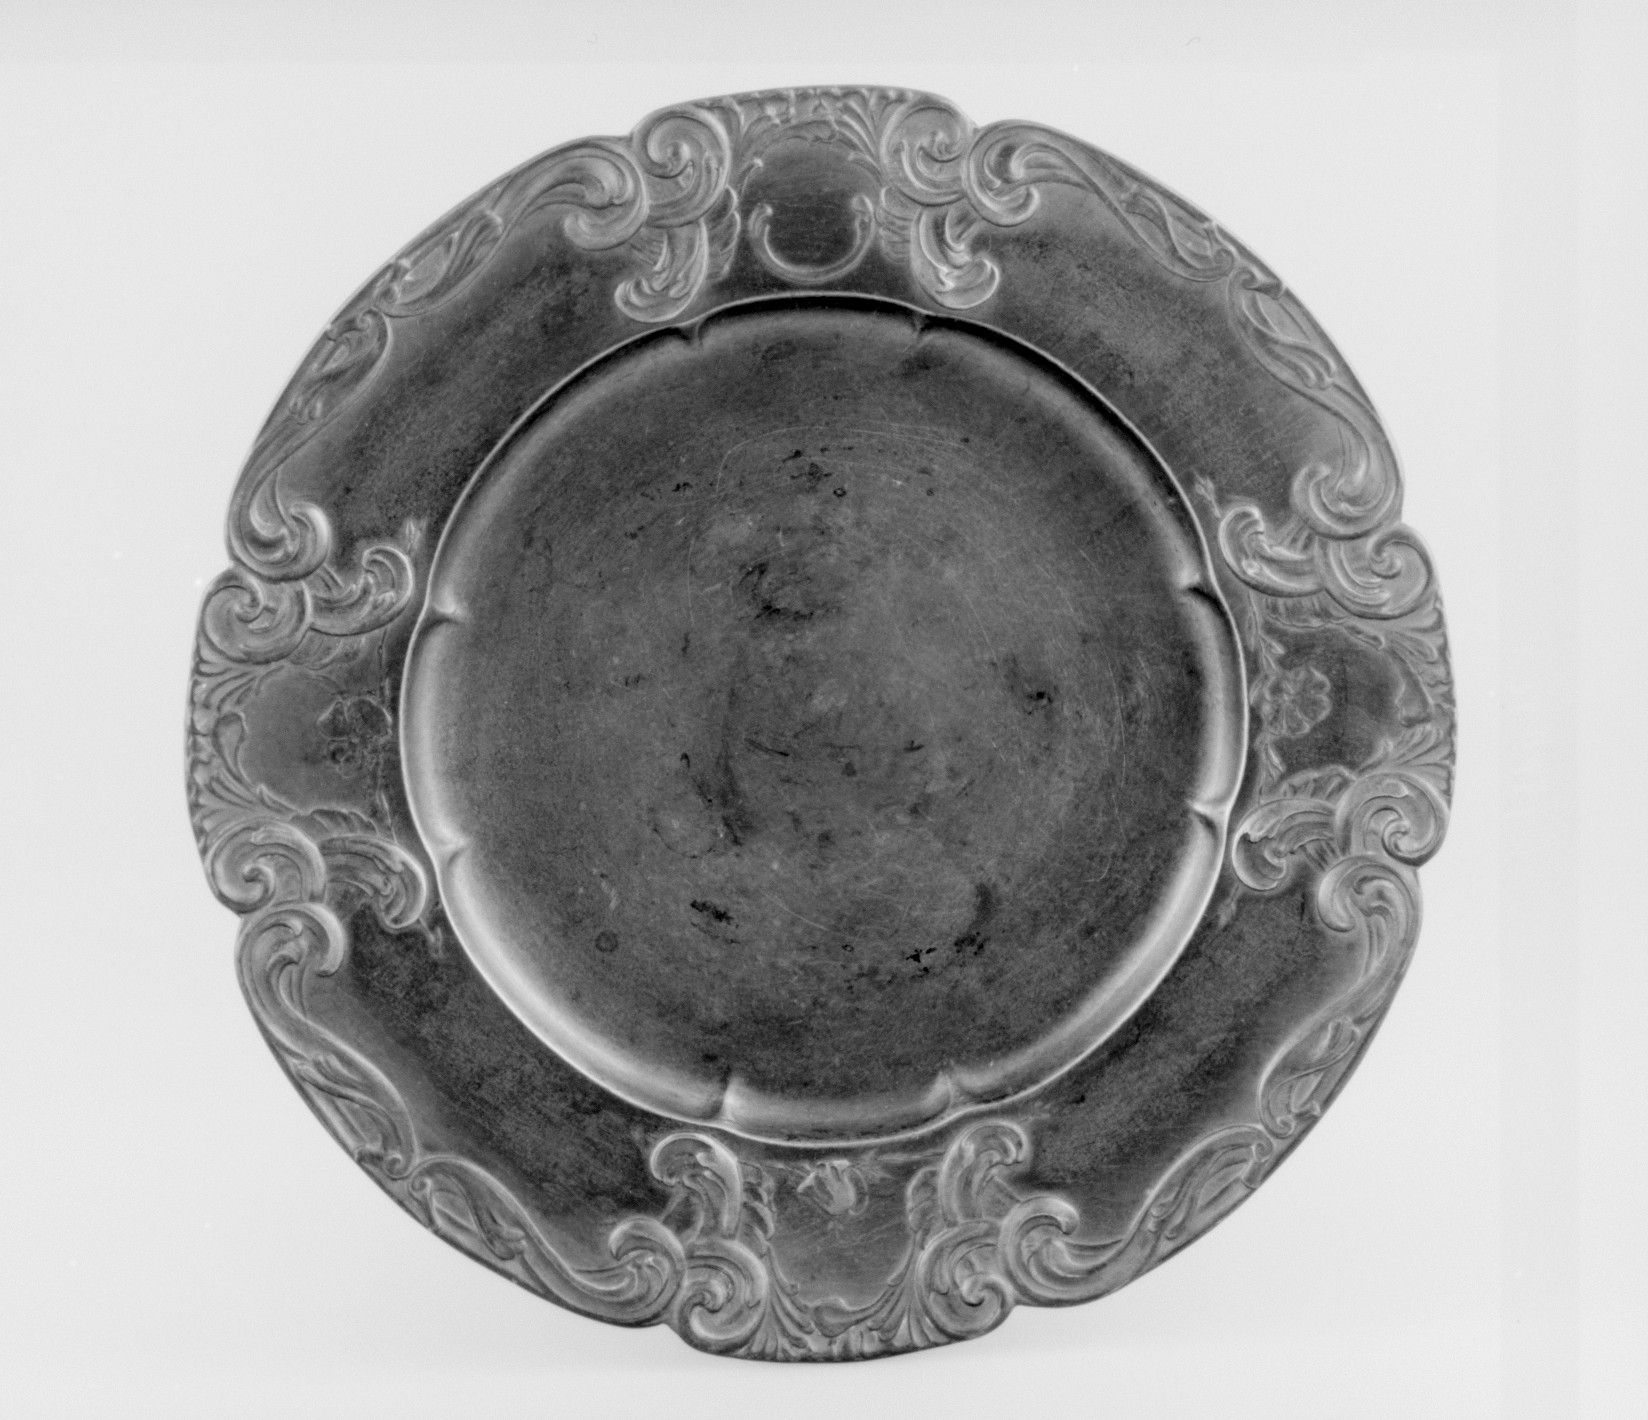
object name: dish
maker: engelbert kayser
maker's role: maker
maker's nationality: german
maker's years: 1840-1911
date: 1890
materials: pewter